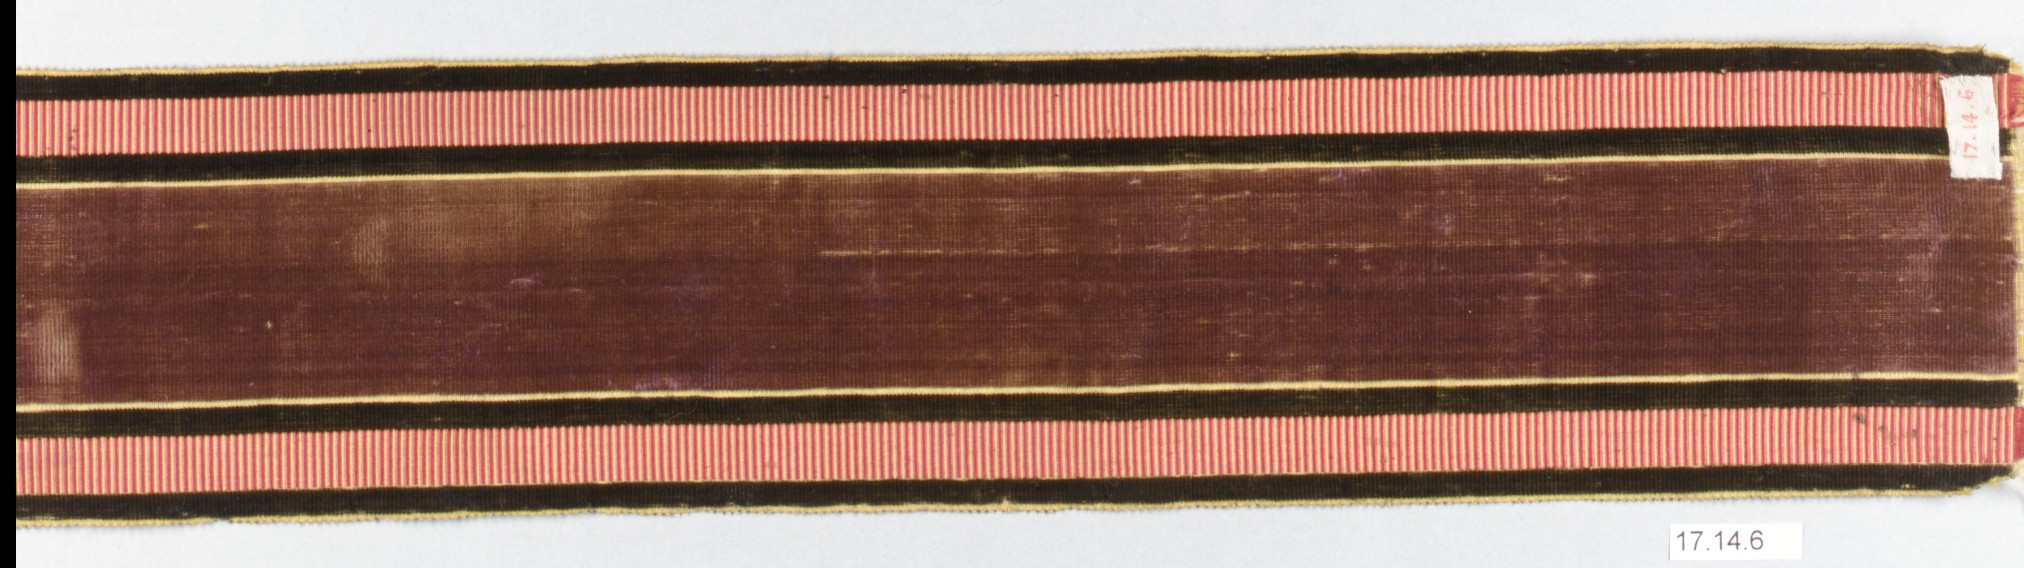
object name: ribbon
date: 1701-1800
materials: velvet